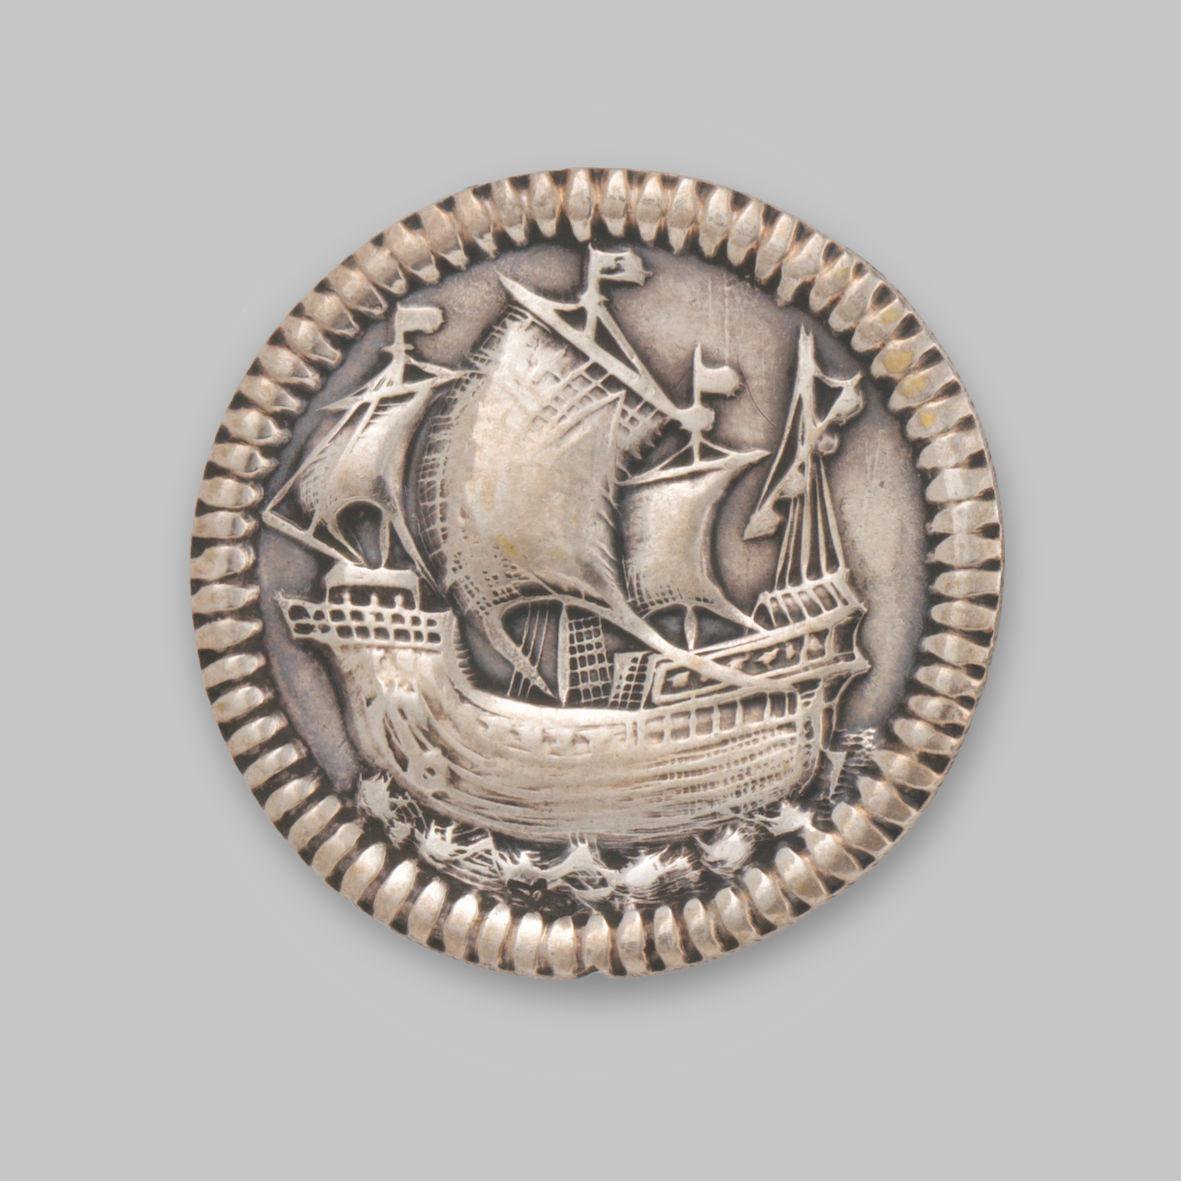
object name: button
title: Knoop met voorstelling van een driemaster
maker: Anonymous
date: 1850-1900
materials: silver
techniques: casting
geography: netherlands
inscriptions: alloy mark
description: Knoop van gegoten zilver, rond, met op de voorzijde een driemaster omgeven door een geribde rand. Aan de achterzijde is een uit gebogen draad vervaardigd oog bevestigd.